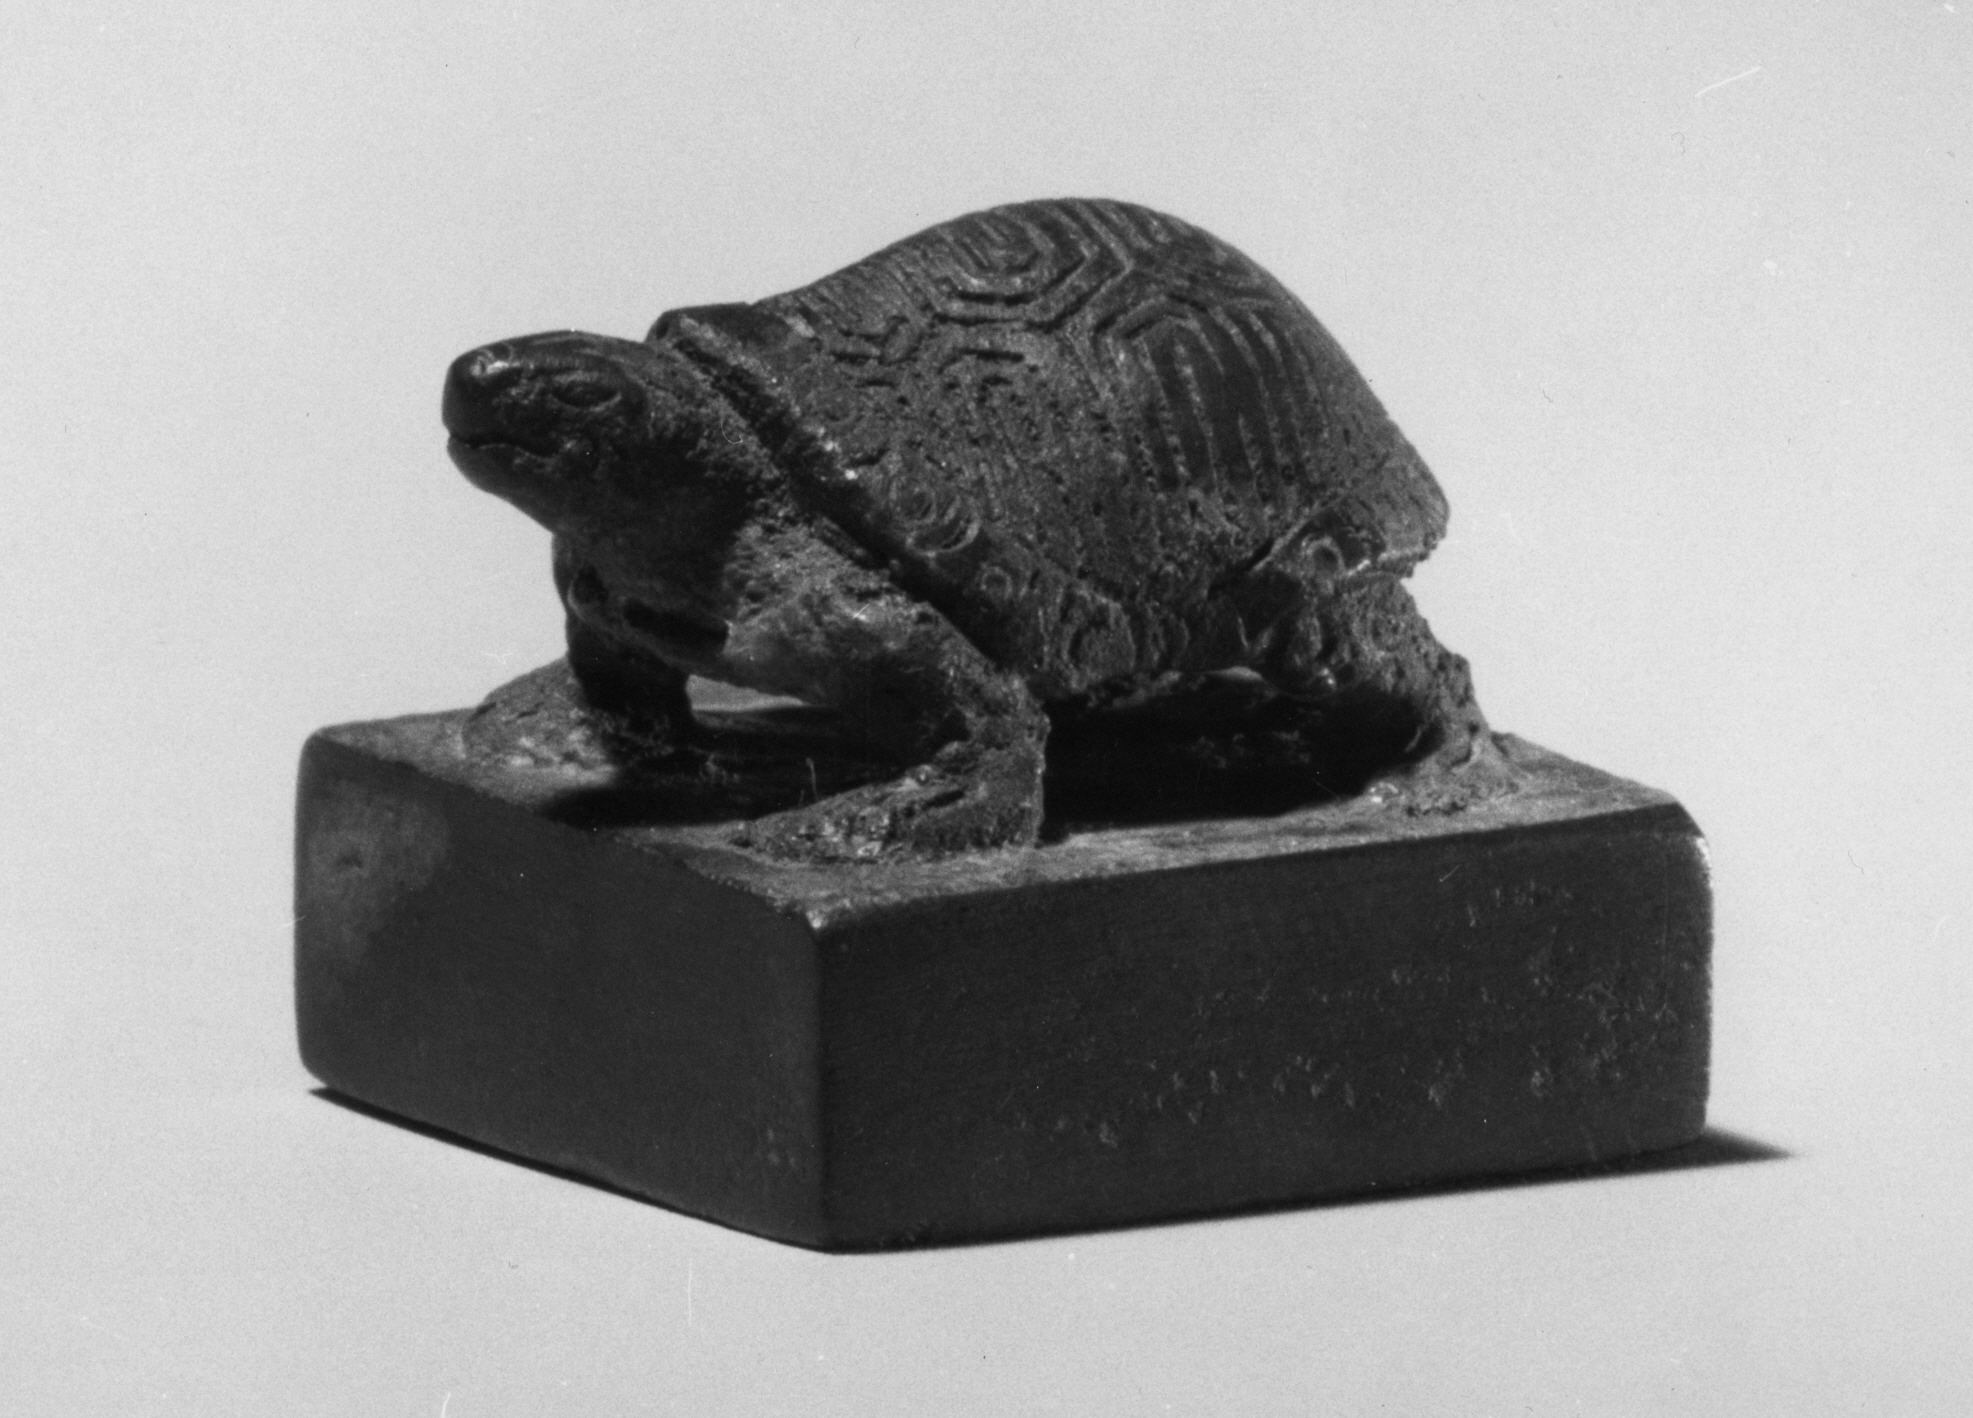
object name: seal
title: Seal with Knob in the Shape of a Turtle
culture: chinese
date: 1-200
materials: bronze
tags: turtles